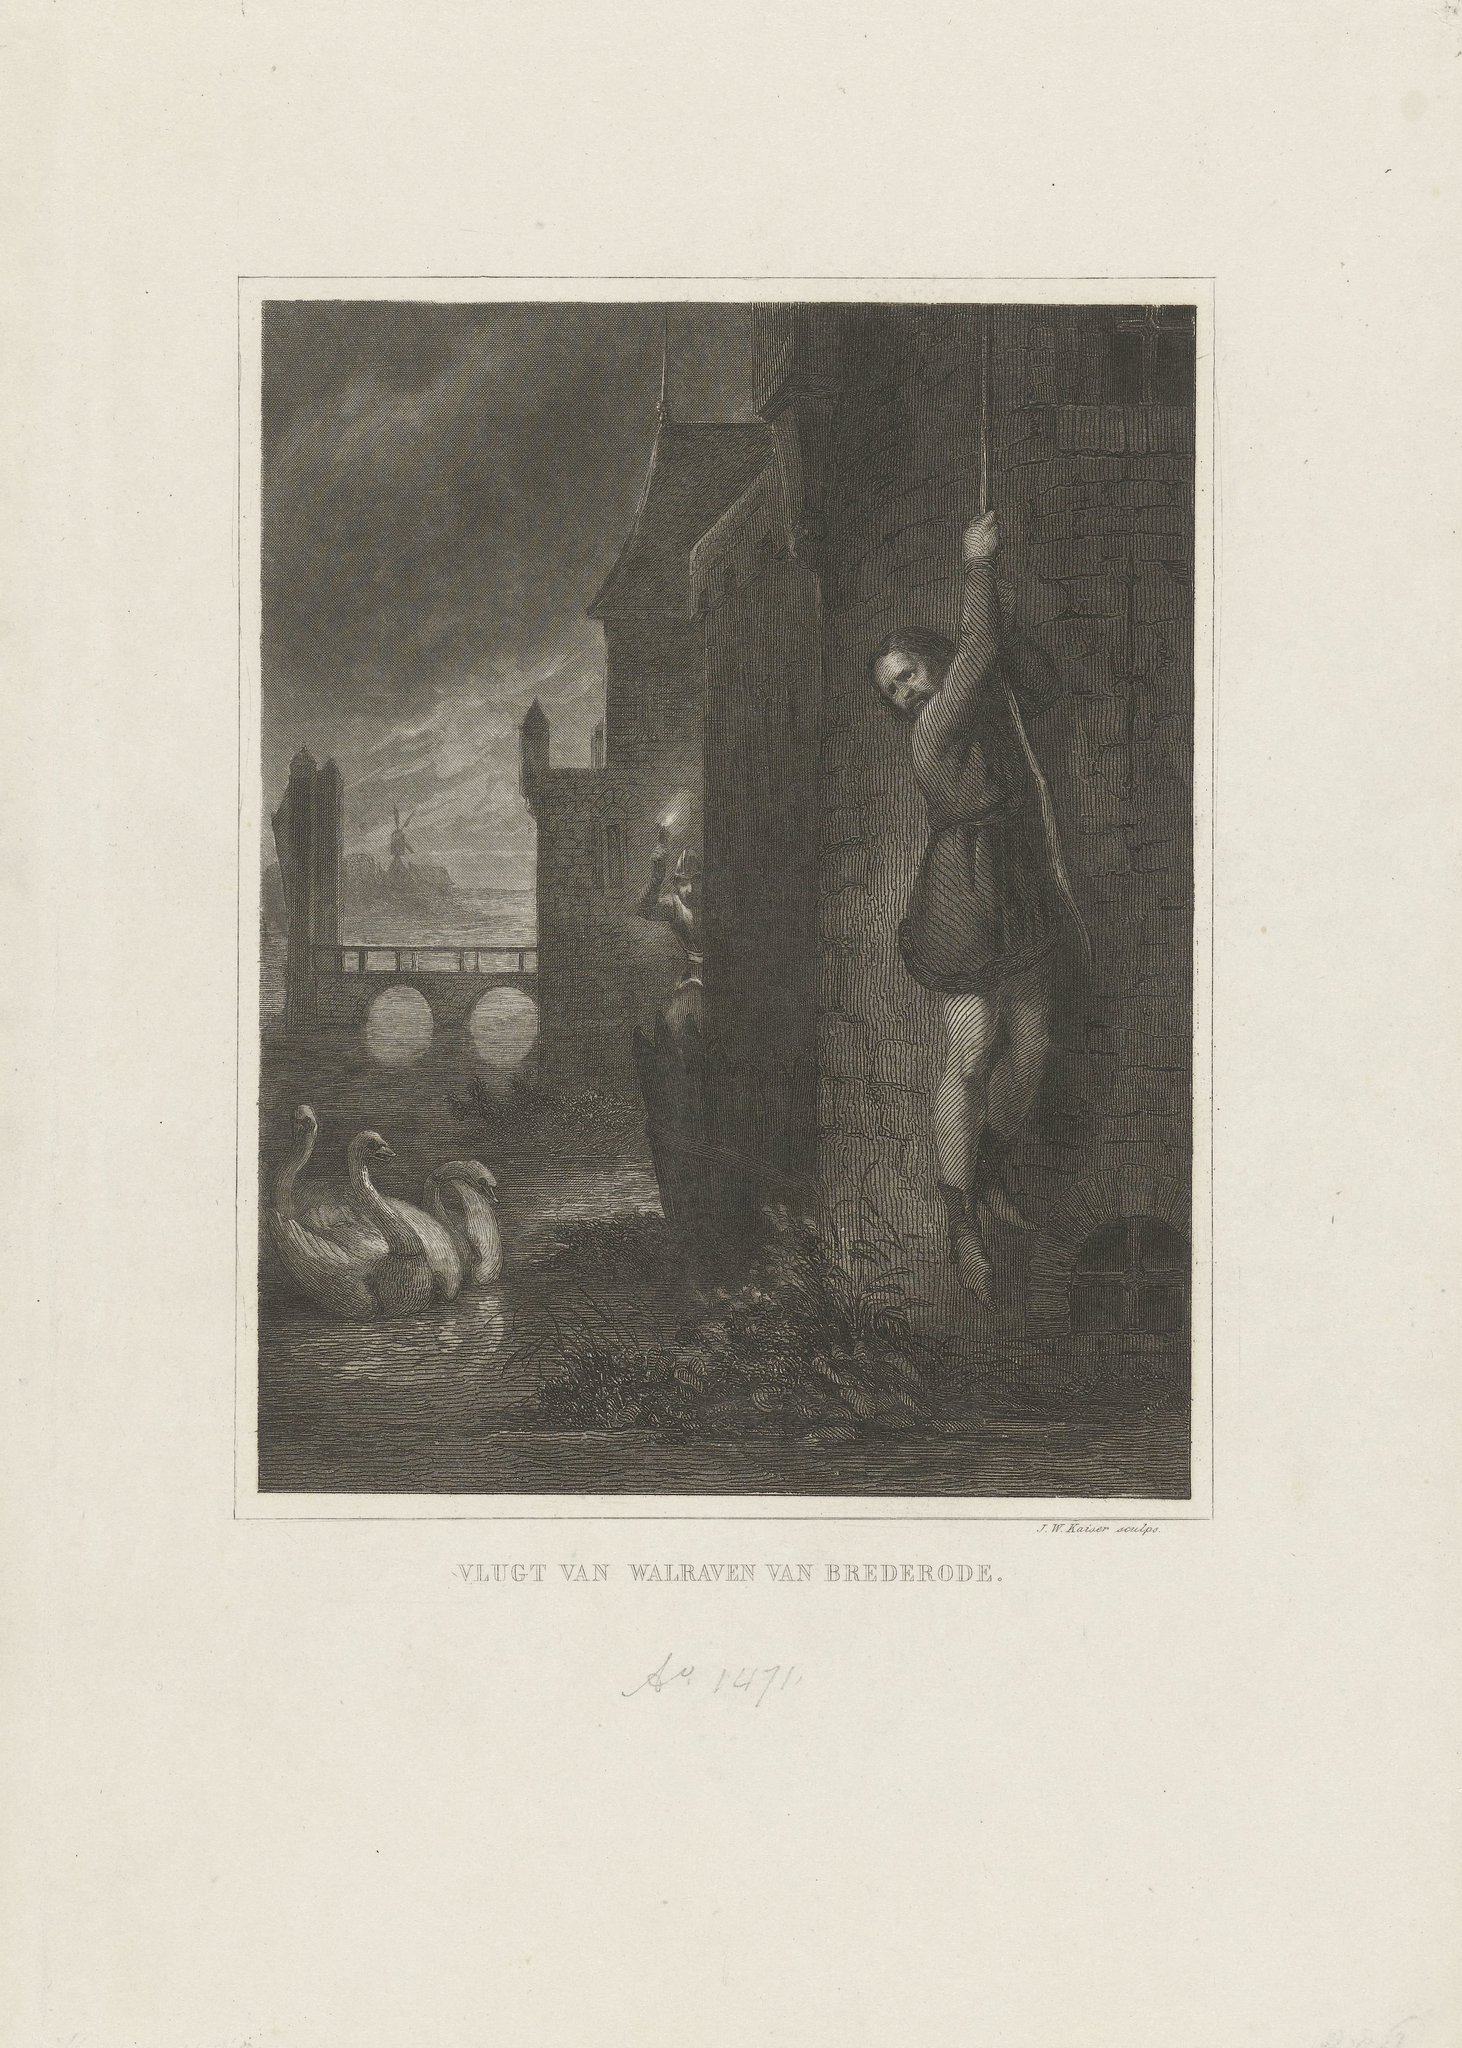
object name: print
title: Vlucht van Walraven van Brederode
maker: johann wilhelm kaiser (i)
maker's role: draughtsman, print maker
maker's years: 1813-1900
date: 1840-1884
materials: paper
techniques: engraving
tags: windmill, wijk bij duurstede, burgundian netherlands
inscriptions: collector's mark: Lugt 2228, inscription: ‘A 1471’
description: Illustratie in: Arend, Johannes Pieter. Algemeene geschiedenis des vaderlands van de vroegste tijden tot op heden. 5 delen, Amsterdam: Schleijer, J.F. 1840-1884, dl 2.3, p. 104.